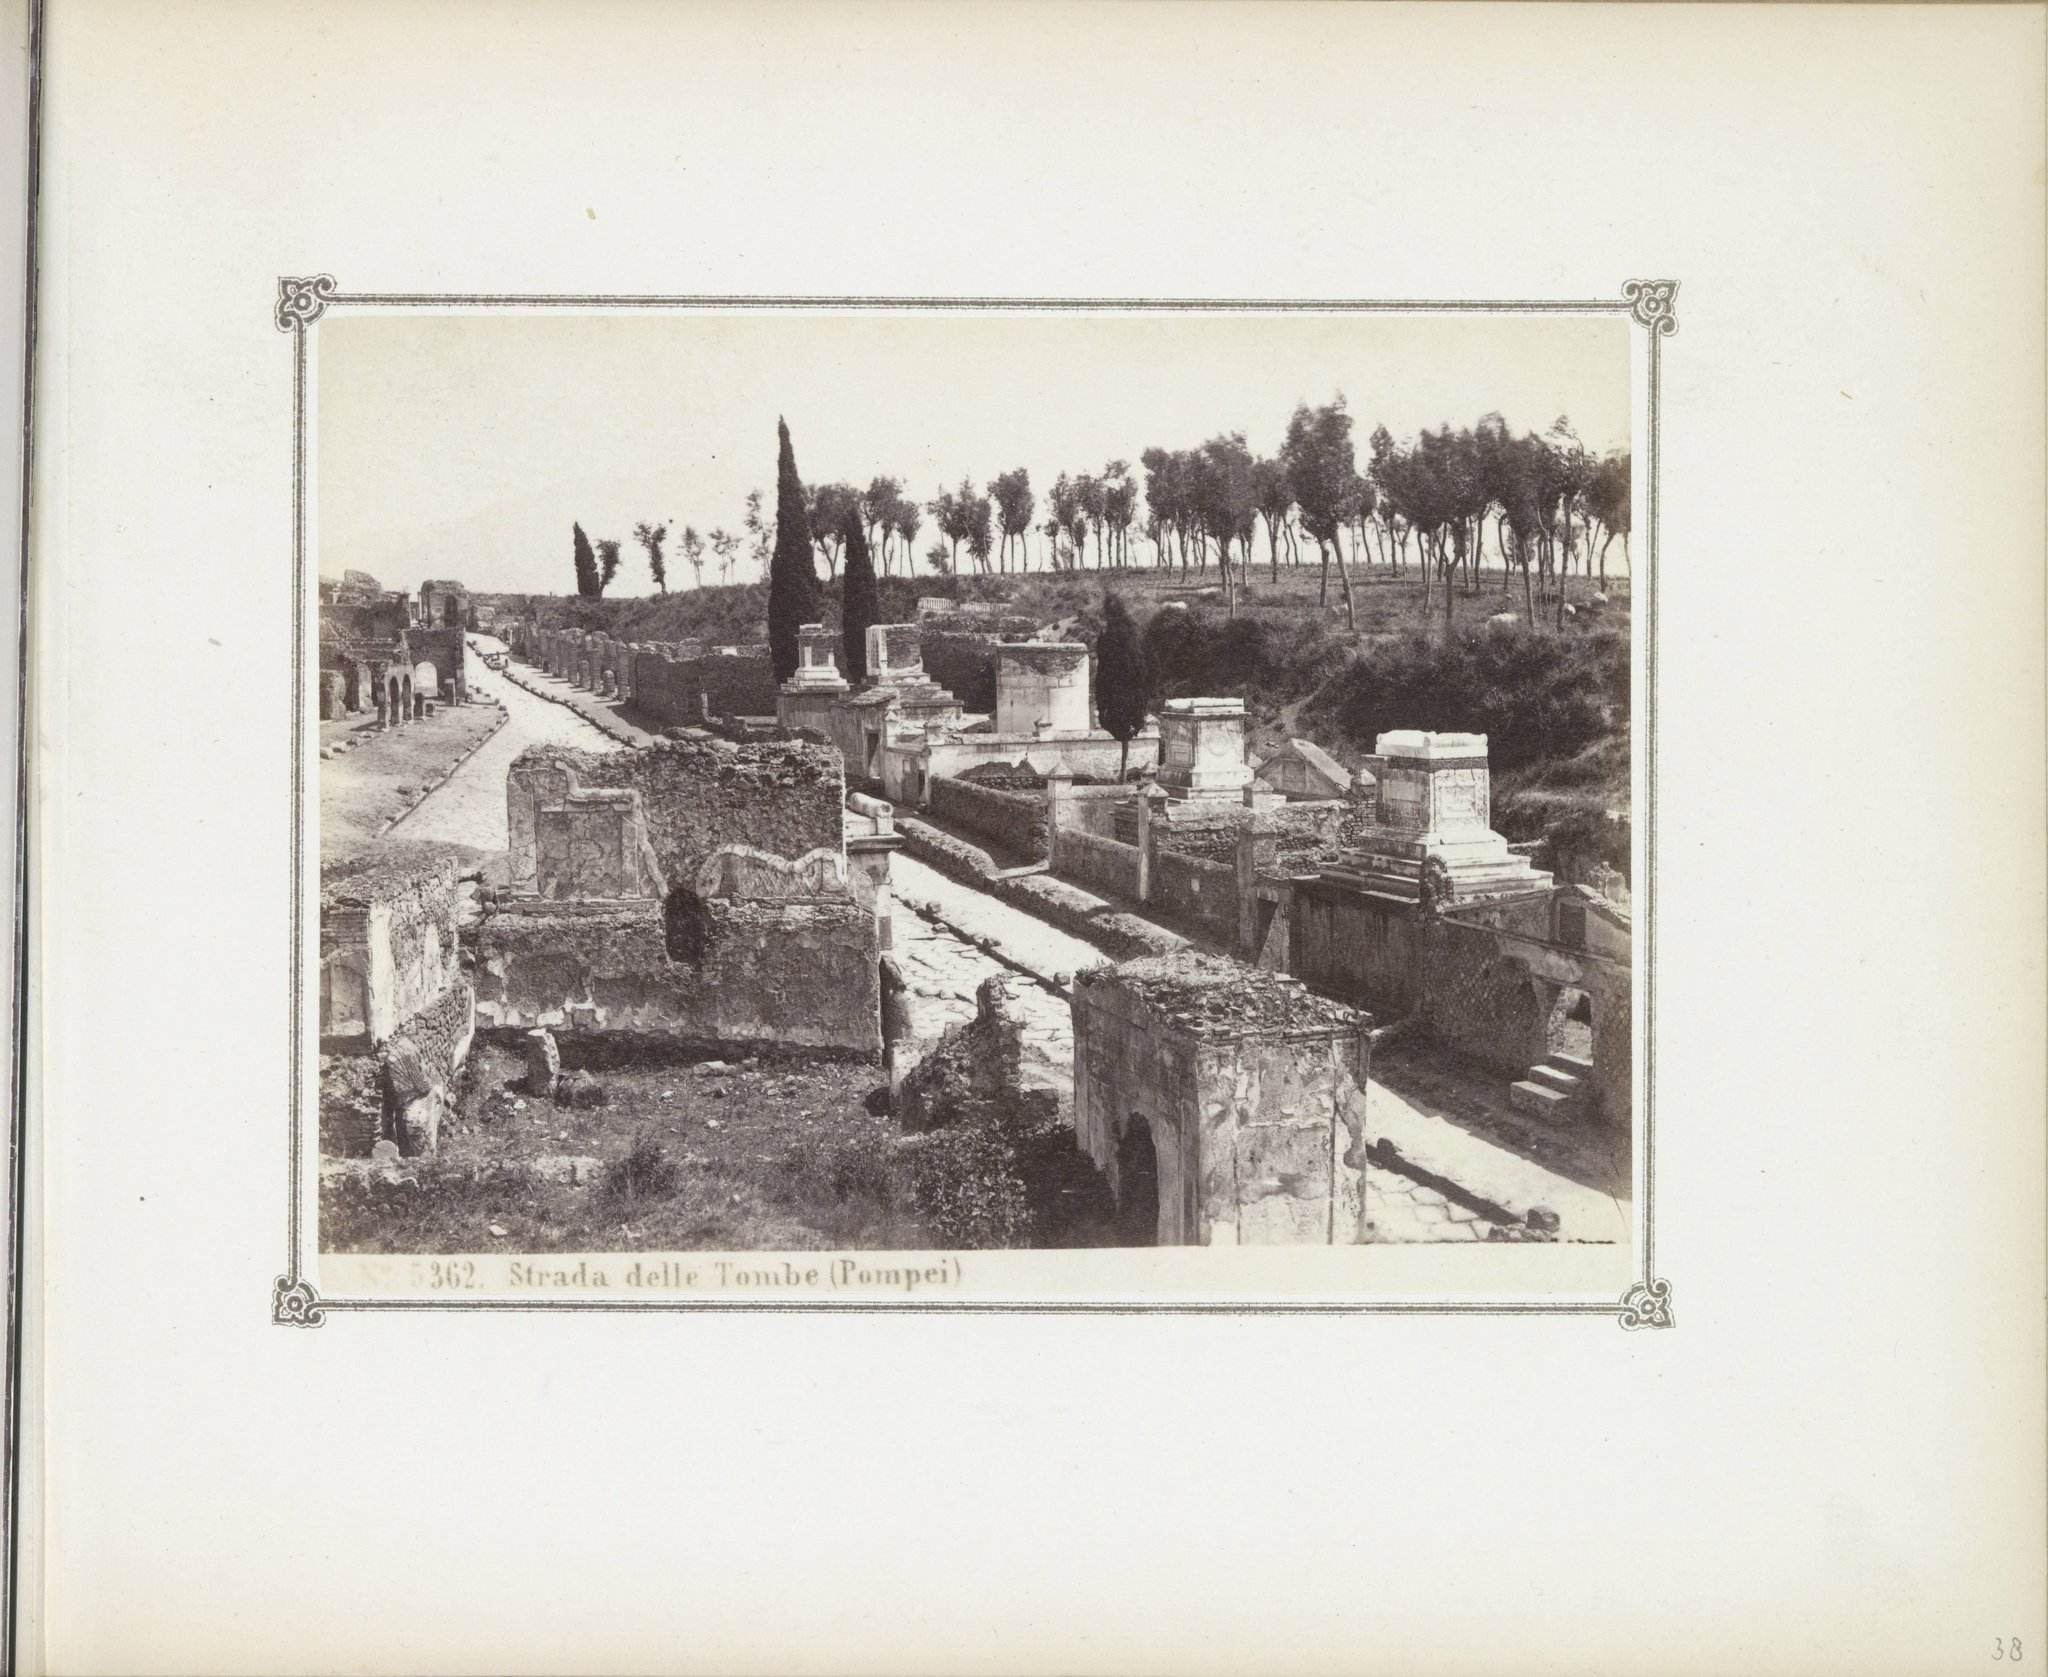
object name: photograph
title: Straat met restanten van graftombes in Pompeï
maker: giorgio sommer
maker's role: fotograaf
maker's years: 1834-1914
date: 1860-1900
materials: paper, photographic support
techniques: albumen print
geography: pompeii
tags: grave, tomb, excavation ~ archaeology, street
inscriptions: number: ‘5362’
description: Onderdeel van Fotoalbum met opnames van opgravingen in Pompeï door Giorgio Sommer.